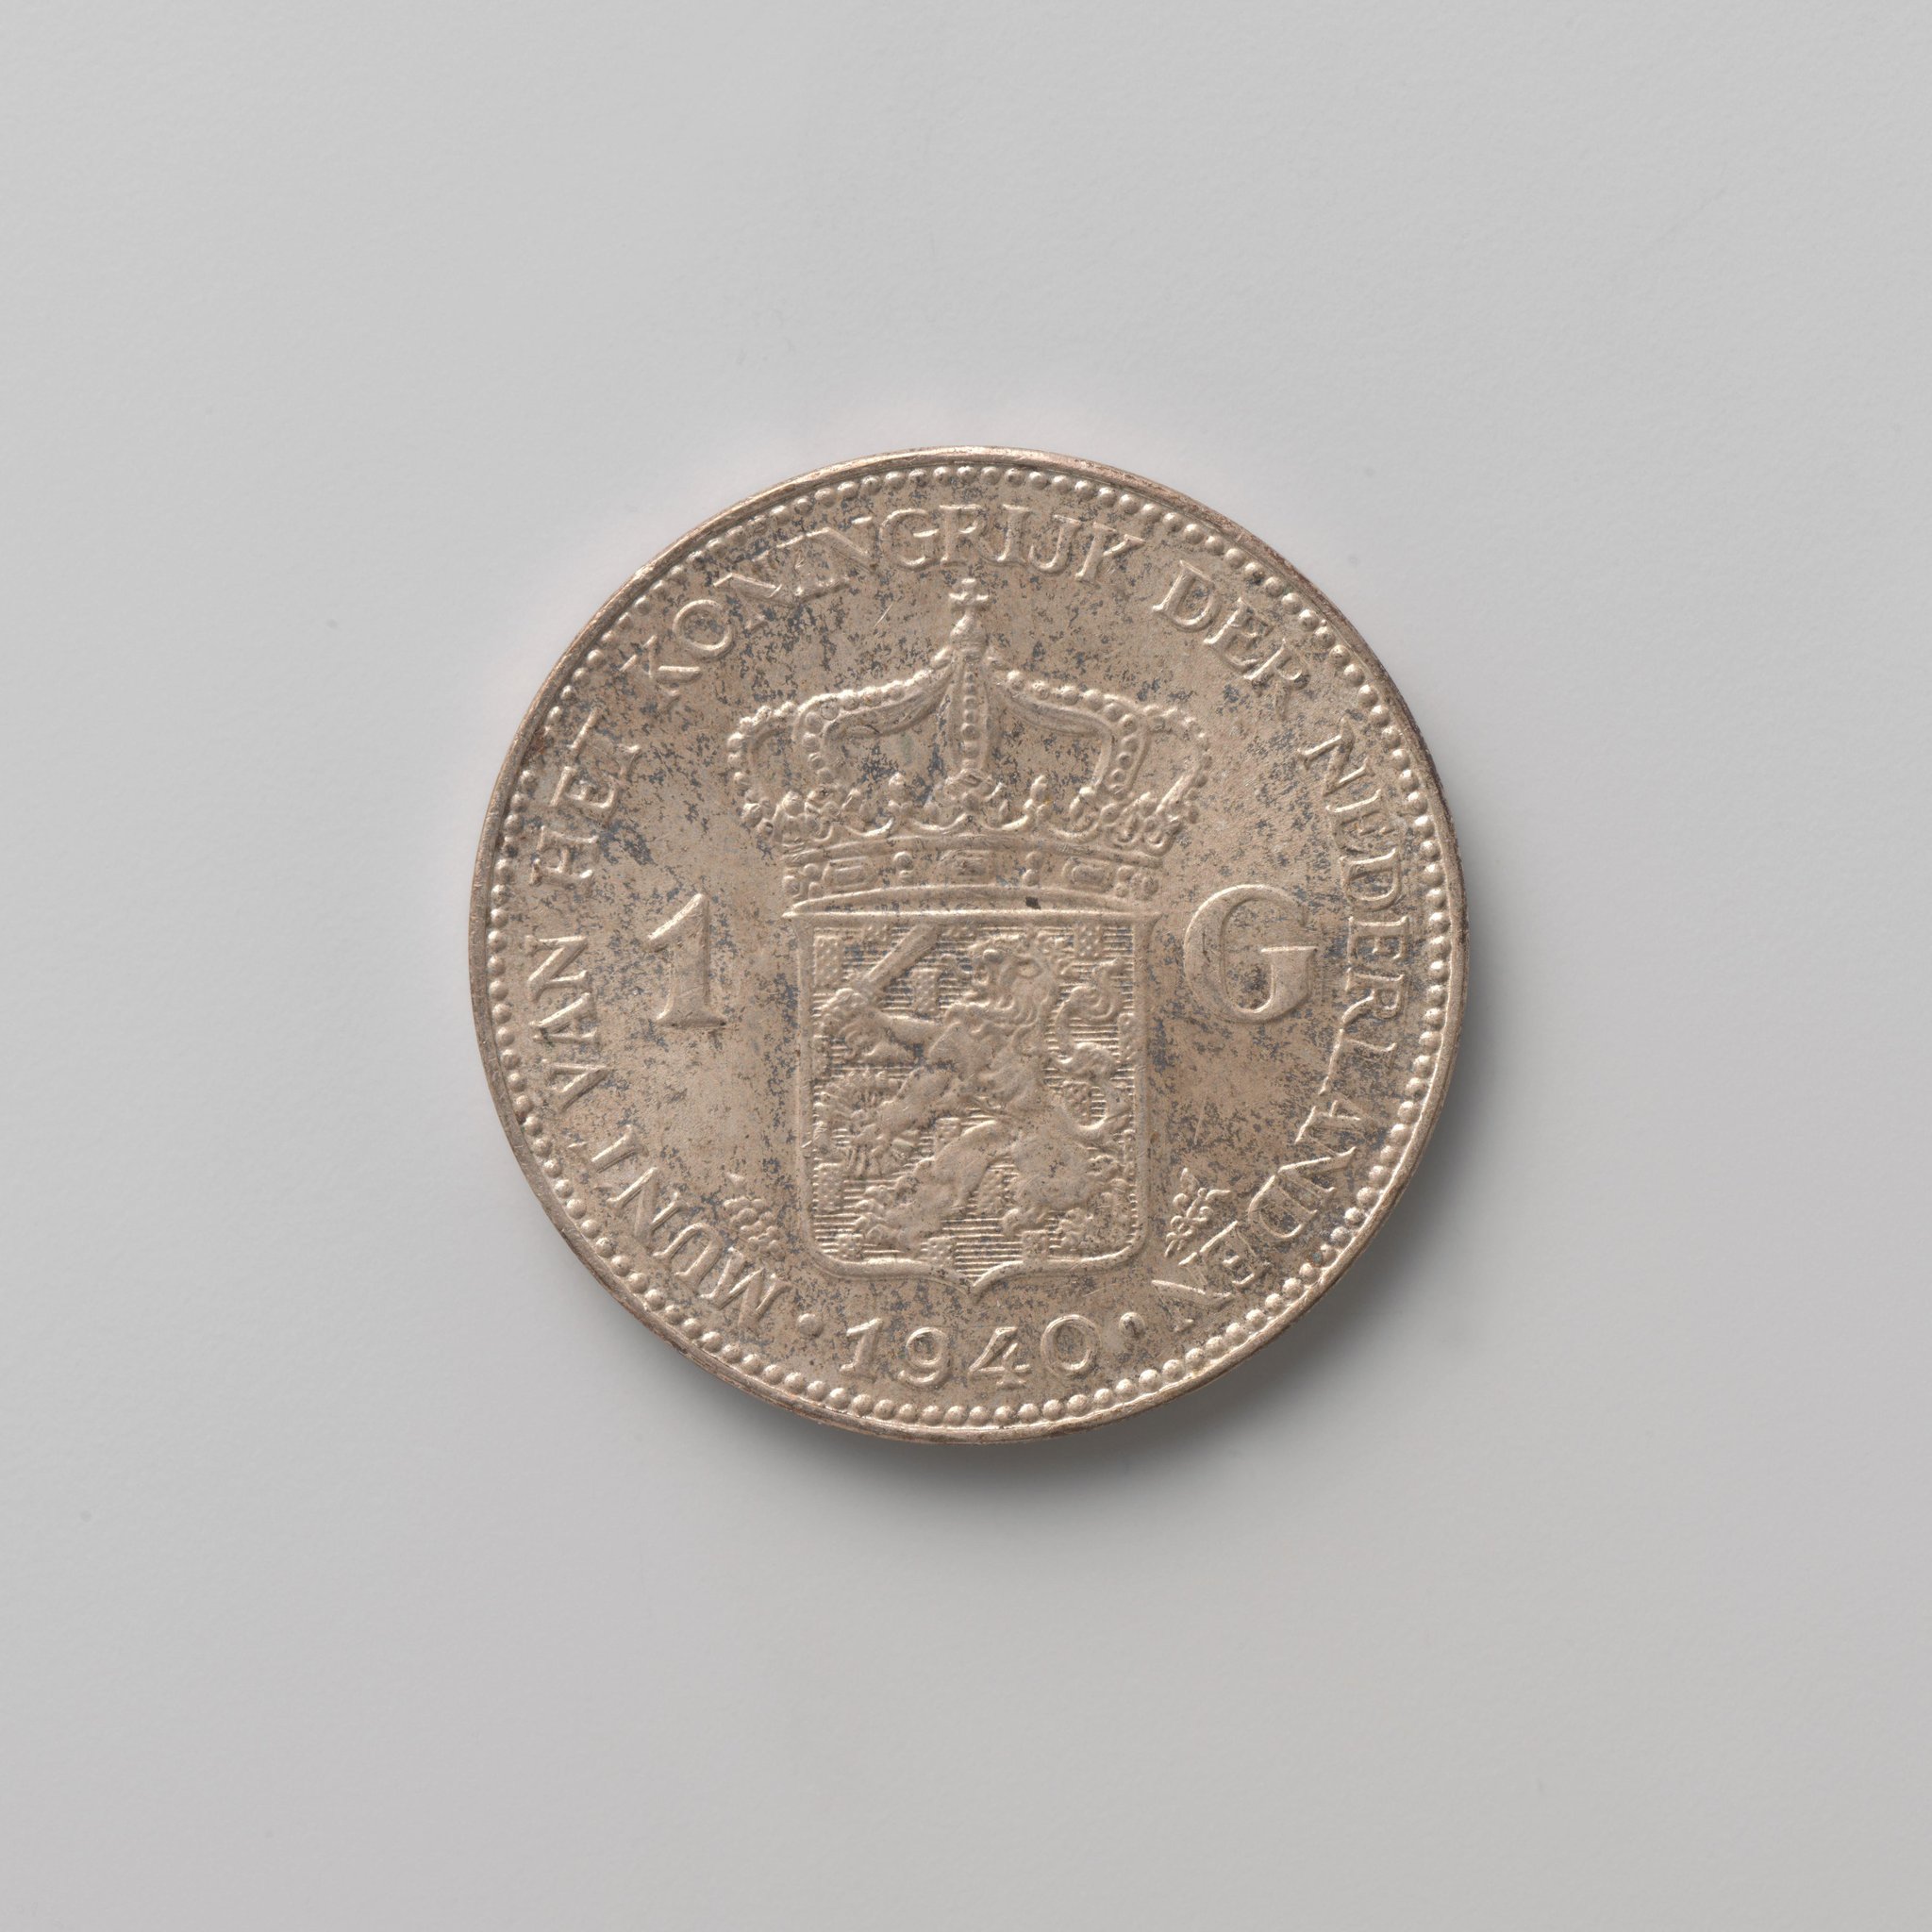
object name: coin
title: Nederland, gulden,1940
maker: wilhelmina of the netherlands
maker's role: print maker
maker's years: 1880-1962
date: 1940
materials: silver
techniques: striking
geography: utrecht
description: Zilveren munt. Voorzijde: hoofd naar links. Keerzijde: tussen waarde-aanduiding 1 G gekroond rijkswapenschild. Jaartal onderaan in omschrift. Randschrift.